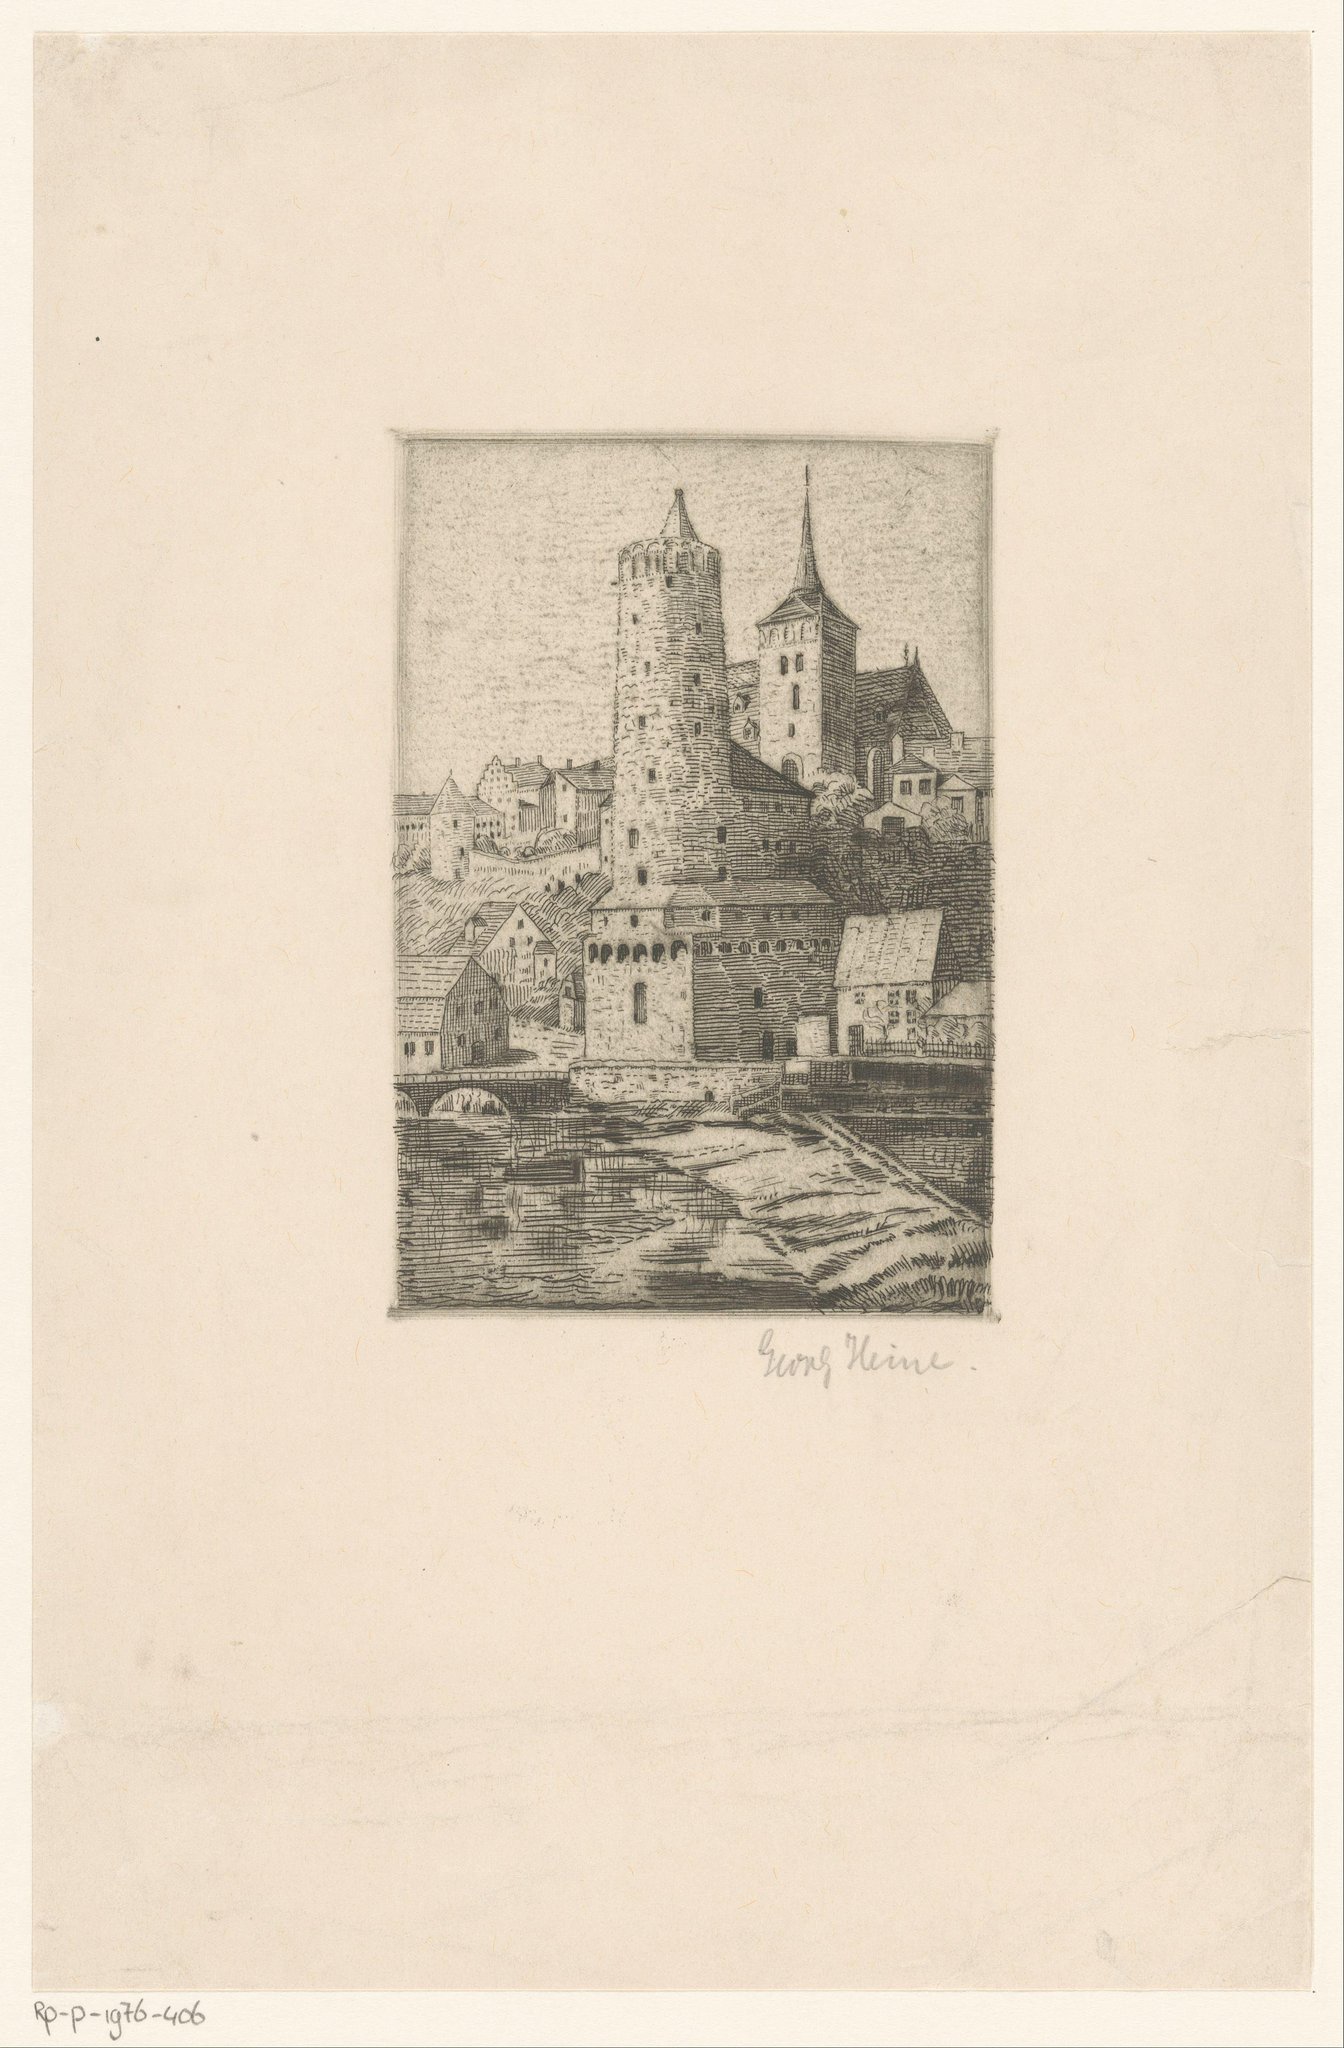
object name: print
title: Stadsgezicht met twee torens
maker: georg heine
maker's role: print maker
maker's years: 1877-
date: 1887-1927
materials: paper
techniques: etching, intaglio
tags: tower, clock tower ~ monumental adornment, city-view in general; 'veduta'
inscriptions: collector's mark: Lugt 2228